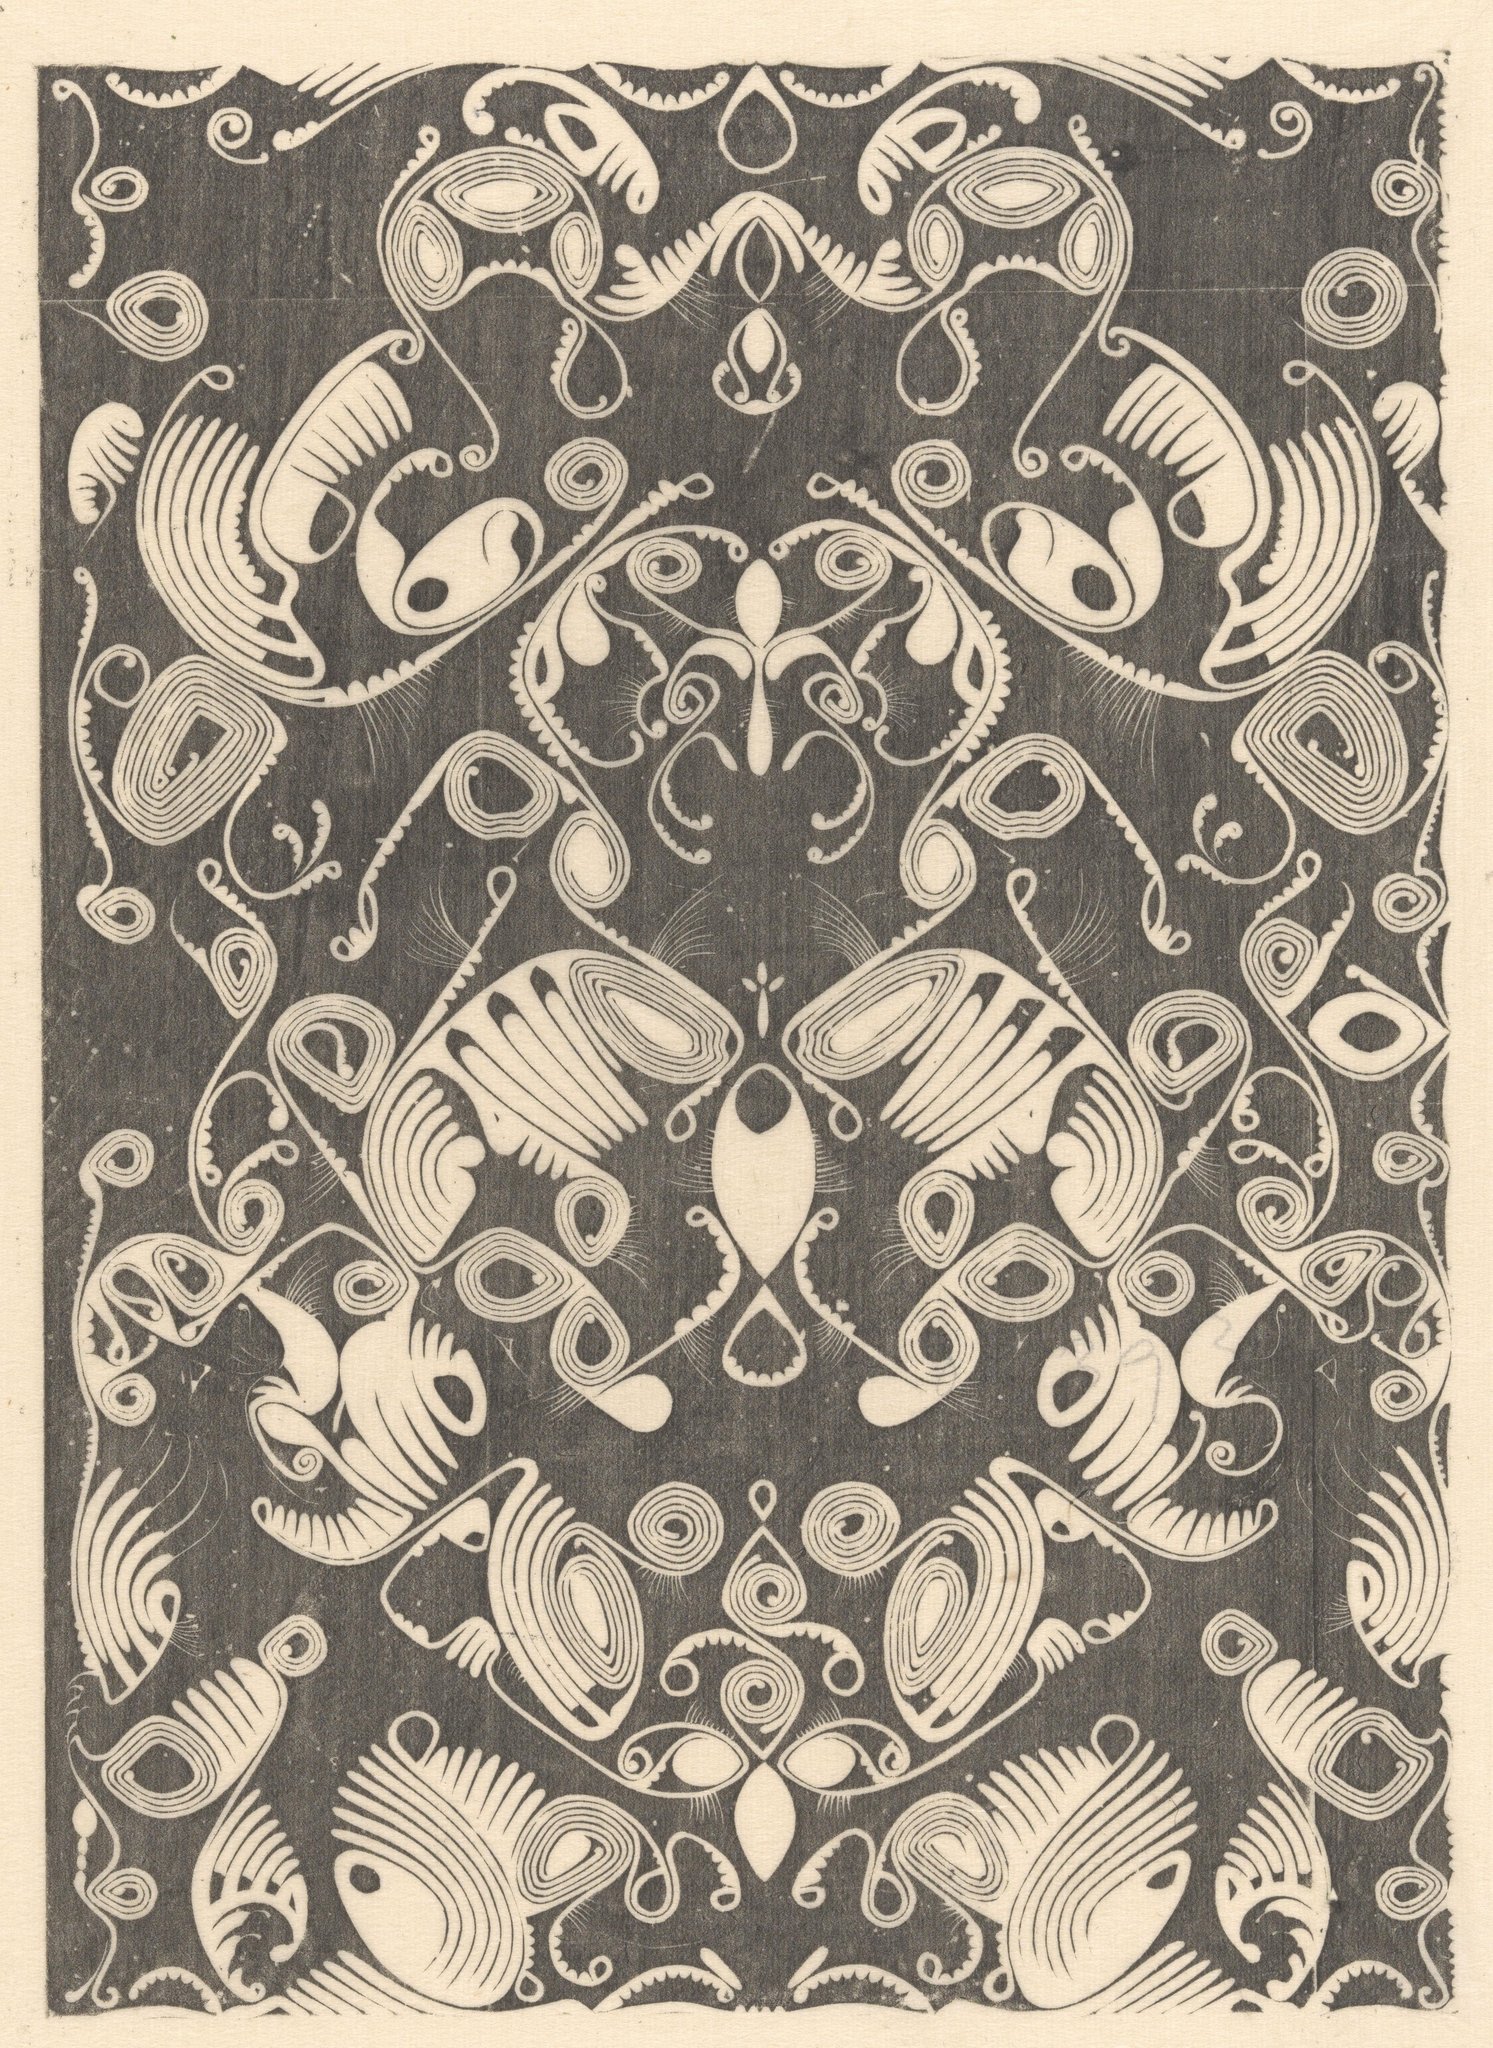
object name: print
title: Schutblad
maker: karel petrus cornelis de bazel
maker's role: draughtsman, print maker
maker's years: 1869-1923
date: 1897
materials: paper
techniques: woodcut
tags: ornamental decoration ~ printed matter, book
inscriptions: collector's mark: Lugt 2228